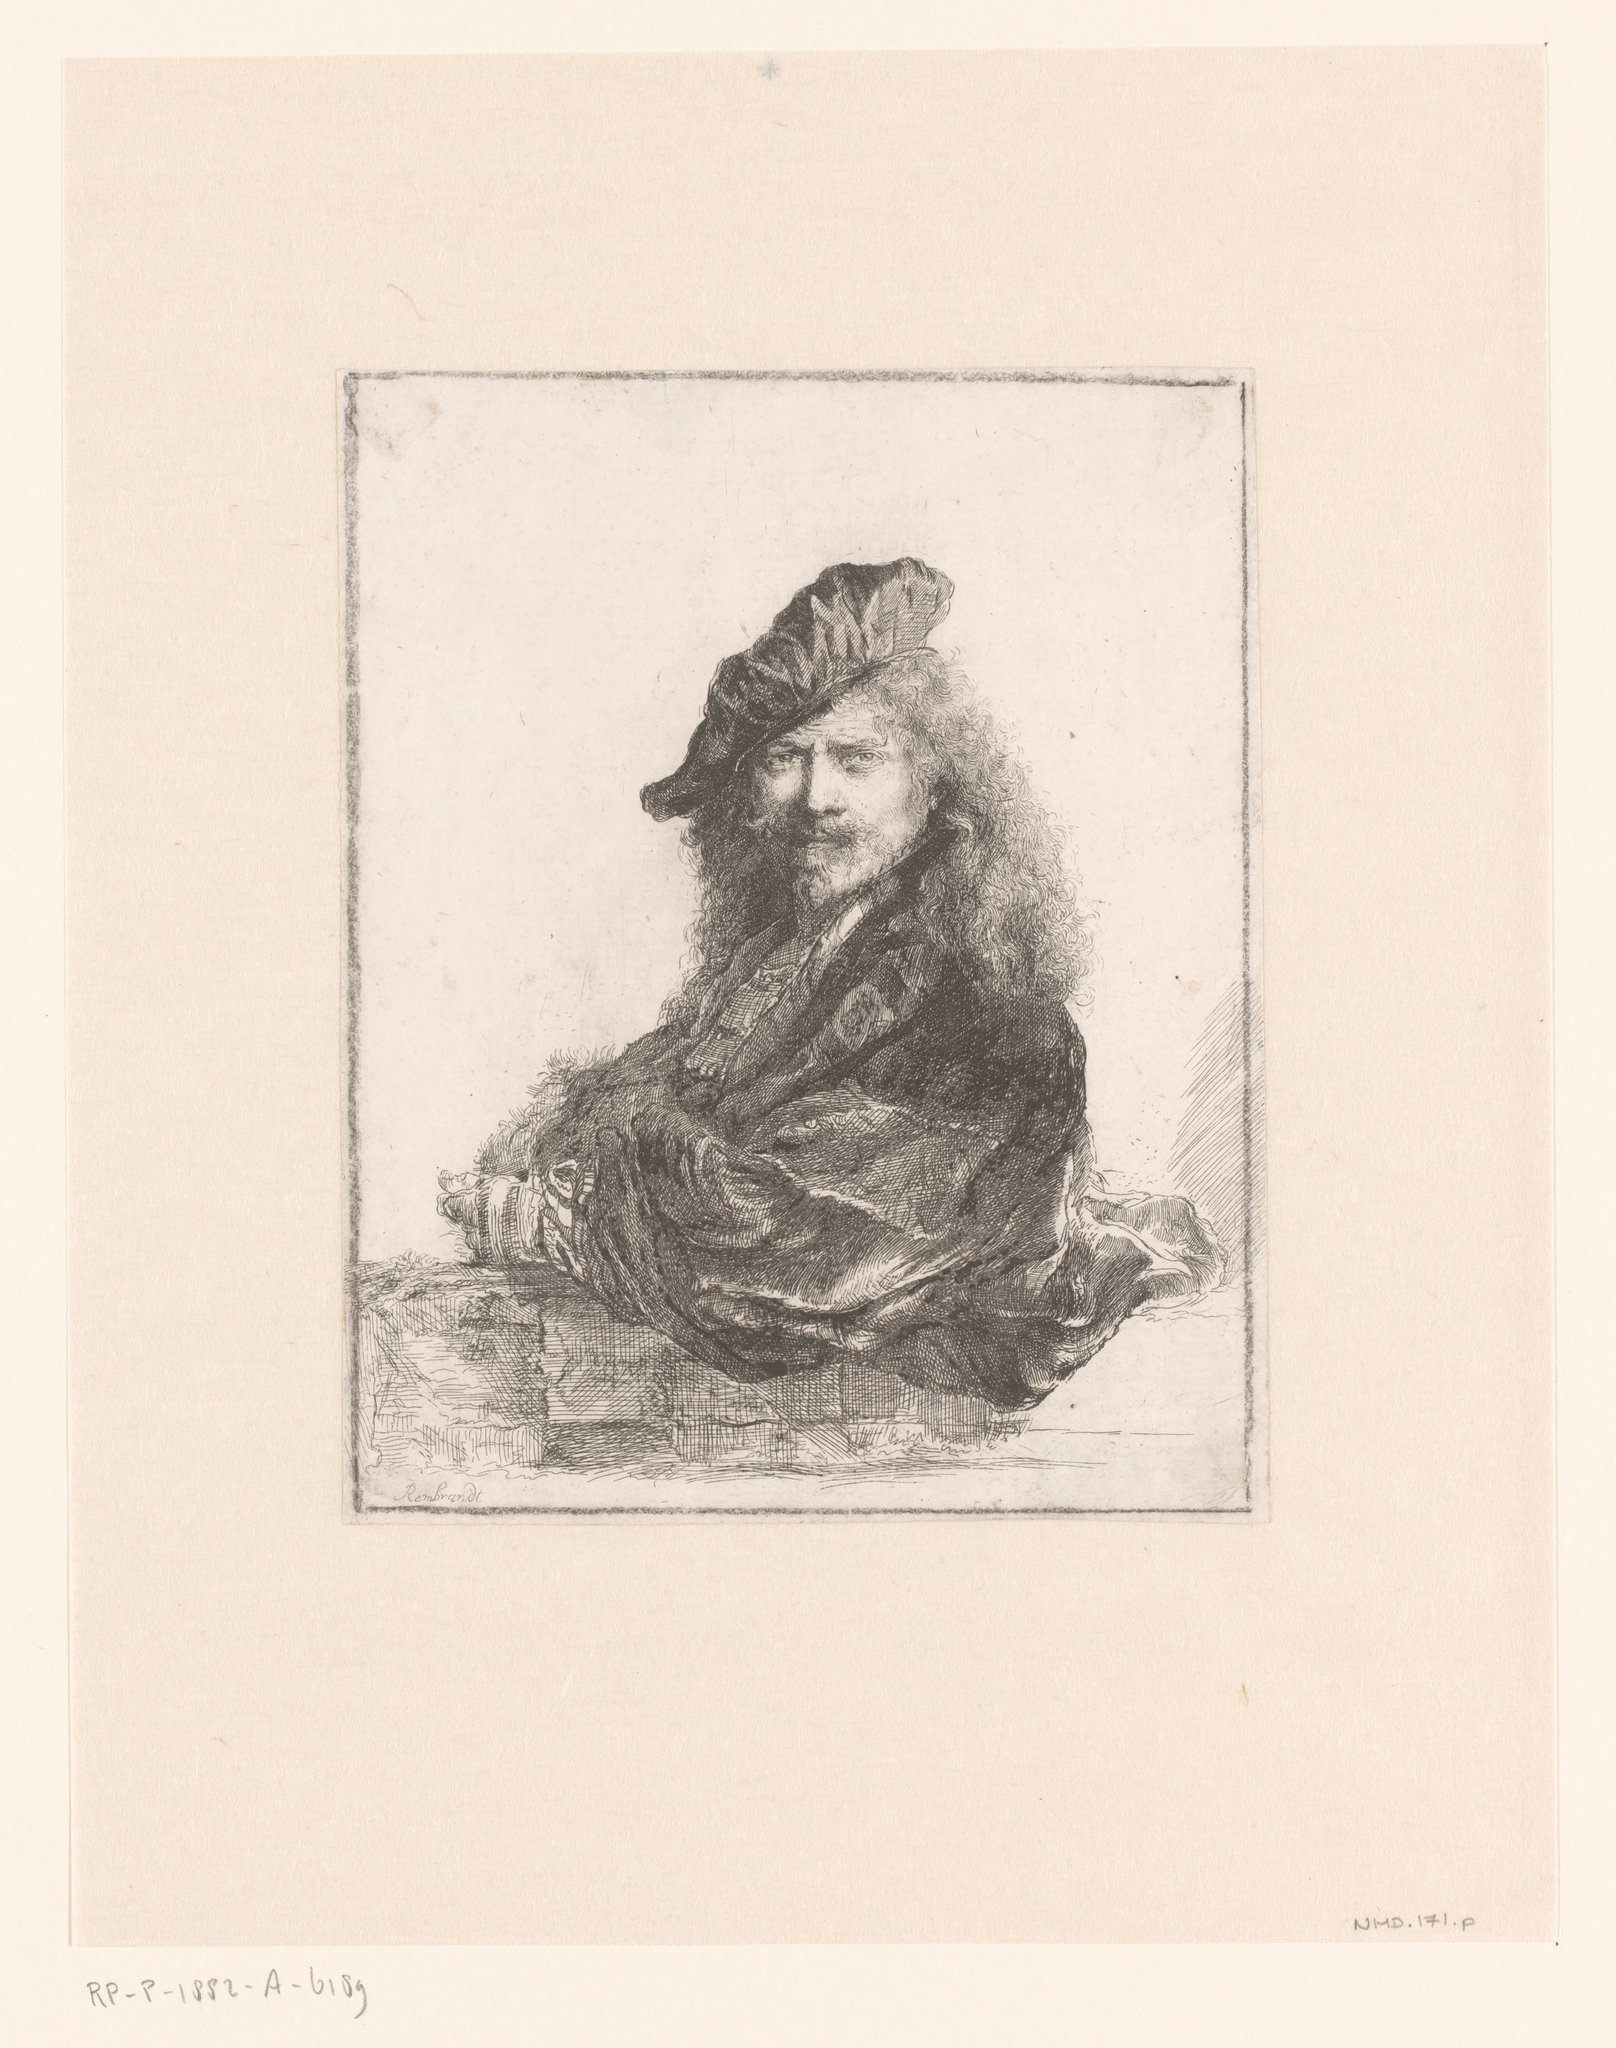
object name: print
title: Self-portrait leaning on a stone sill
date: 1639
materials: chalk, paper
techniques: etching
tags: amsterdam, painter, print maker, draughtsman, rembrandt van rijn, portrait, self-portrait of graphic artist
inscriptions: collector's mark: Lugt 2228